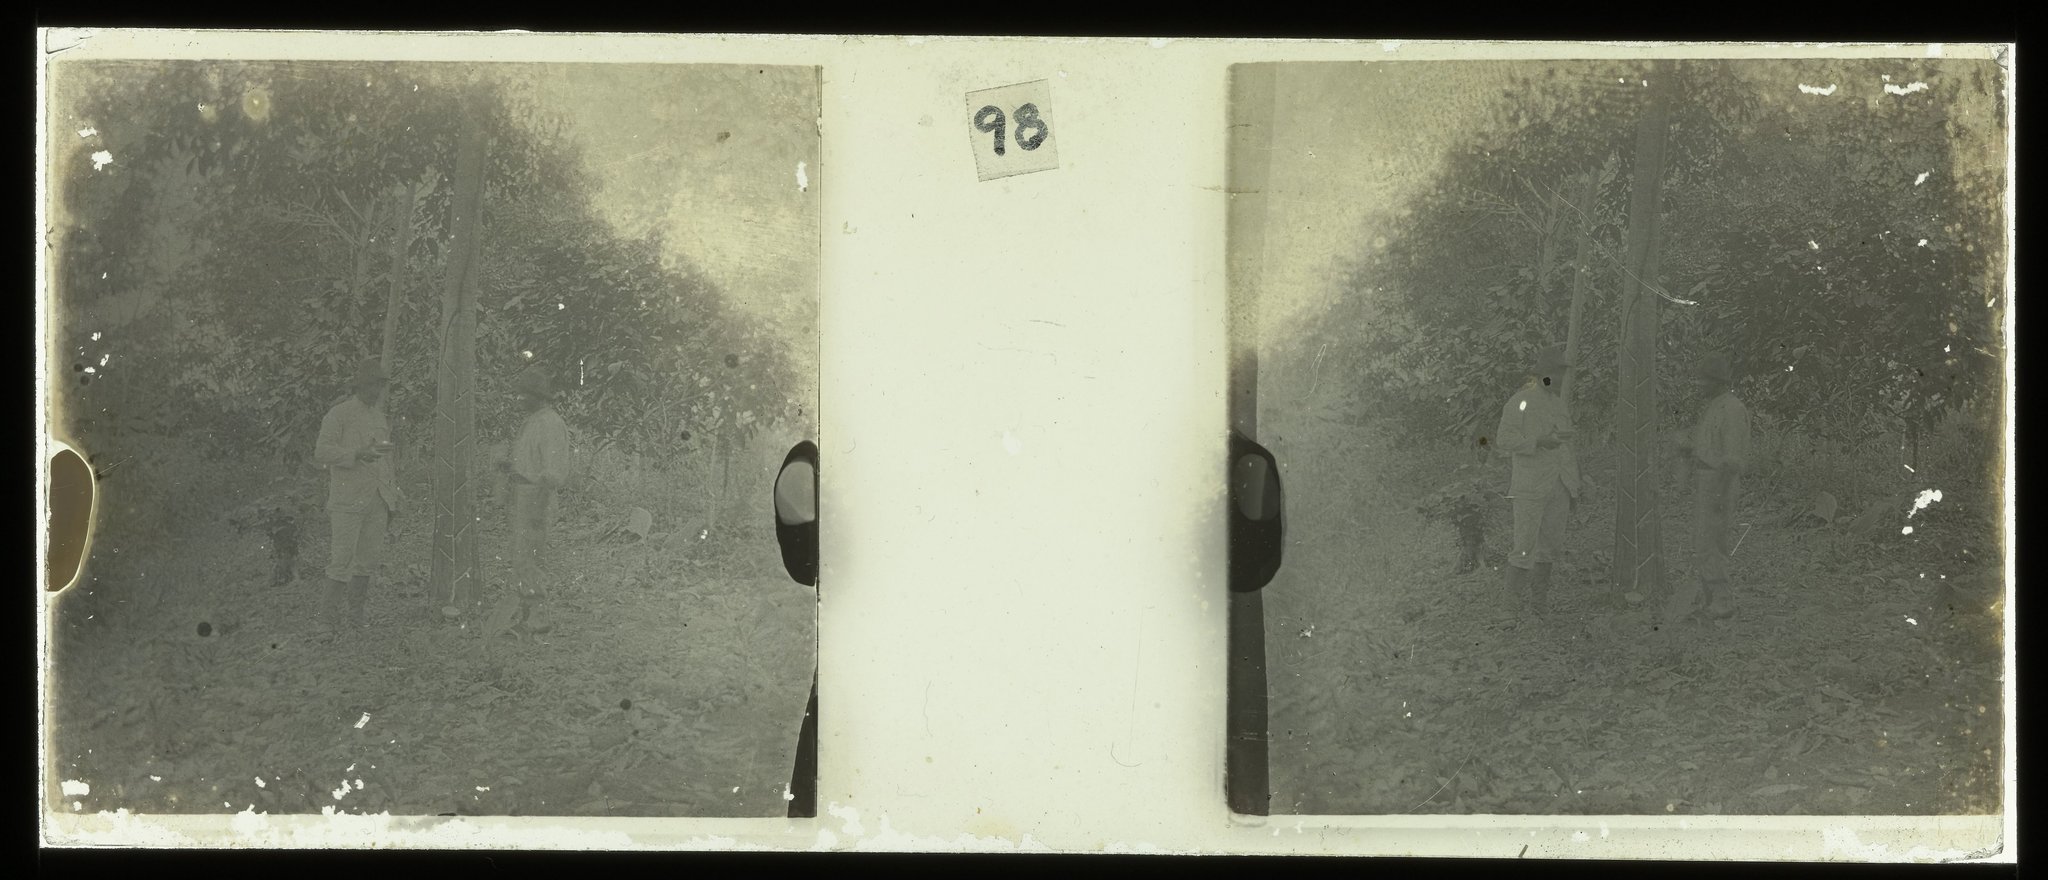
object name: stereograph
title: Plantage Accaribo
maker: theodoor brouwers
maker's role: amateurfotograaf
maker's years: 1874-1932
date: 1913-1930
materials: glass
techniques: photography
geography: suriname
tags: amsterdam, theodoor brouwers, plantation, suriname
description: In de periode 1911-1932 woonde op plantage Accaribo in Suriname de familie Brouwers van wie de foto's afkomstig zijn. Rond 1910 vond Theodoor Brouwers werk op plantage Accaribo. In 1929 werd hij eigenaar van de plantage. Op Accaribo werden in zijn tijd bananen geproduceerd en wat koffie.